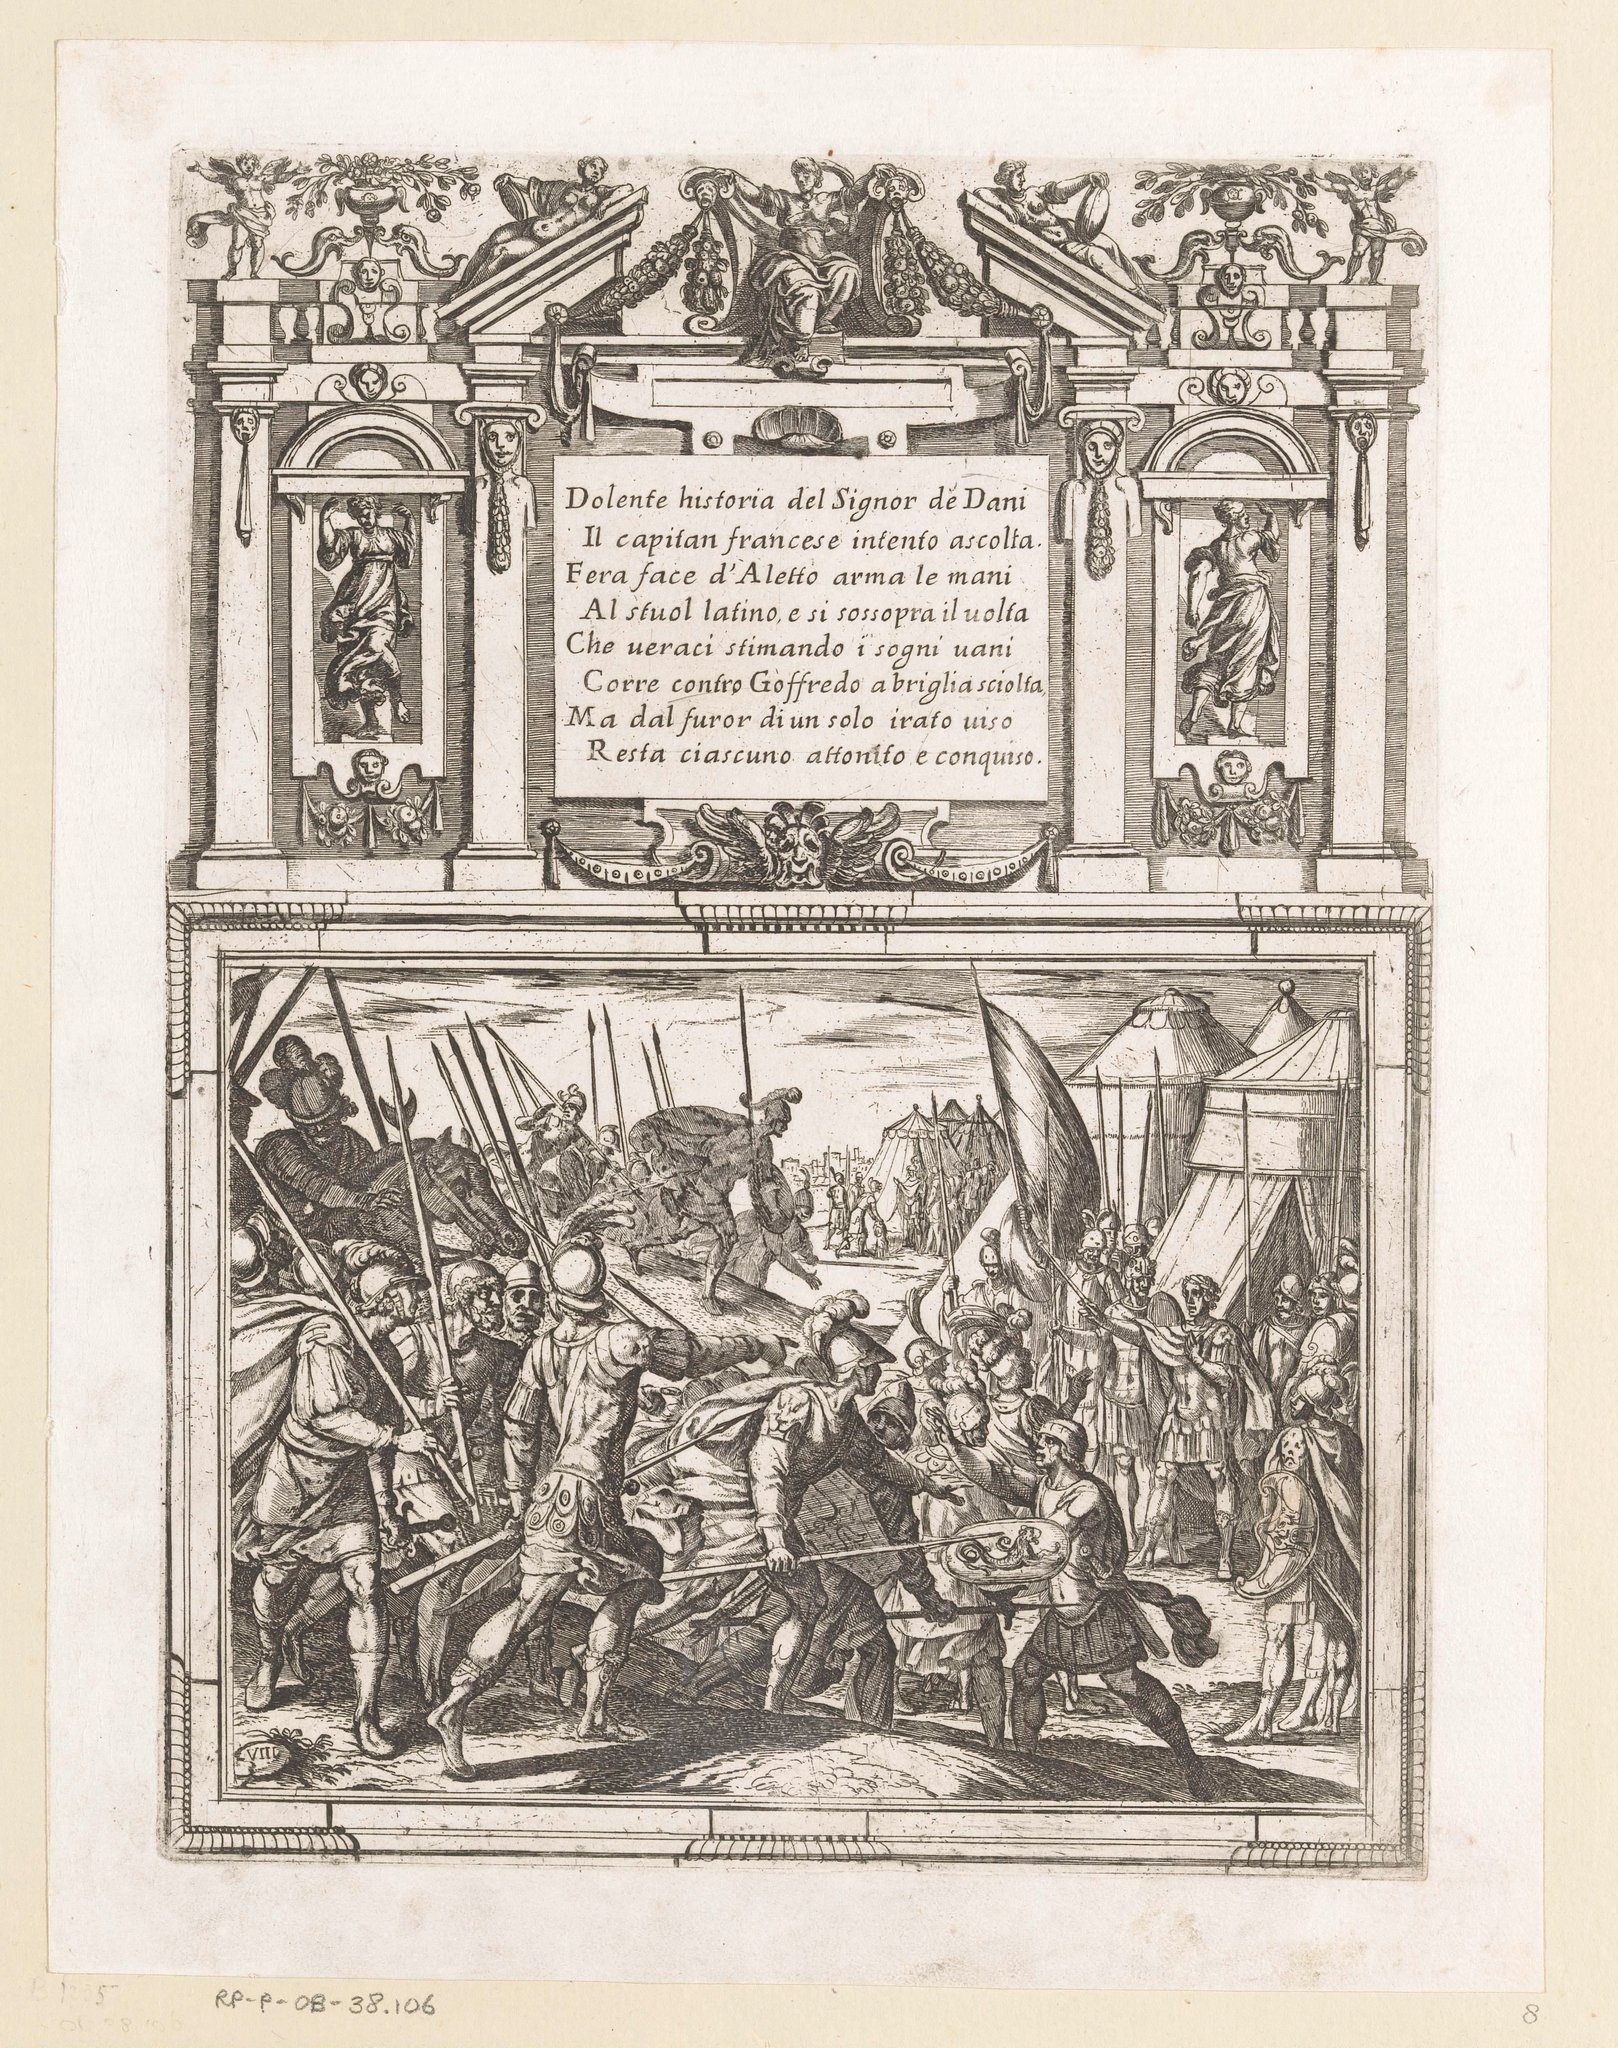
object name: print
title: Illustratie bij Canto VIII van Tasso's 'Gerusalemme Liberata'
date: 1565-1630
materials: paper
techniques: etching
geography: italy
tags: ornaments ~ art, militant proselytizing: religious war, crusade, etc., ornament ~ cartouche, (scenes from) specific works of literature: tasso, gerusalemme liberata, knight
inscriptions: collector's mark: Lugt 240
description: Deze prent maakt deel uit van een reeks van twintig prenten met ornamentele sierlijsten met daarin voorstellingen van scènes uit Tasso's 'Jeruzalem verlost', een episch gedicht geschreven door de Italiaanse dichter Torquato Tasso en voor het eerst gepubliceerd in 1581. Het verhaal vertelt grotendeels in fictie over de Eerste Kruistocht waarin de christenen, geleid door Godfried van Bouillon, de strijd aangaan met de moslims om het Beleg van Jeruzalem.